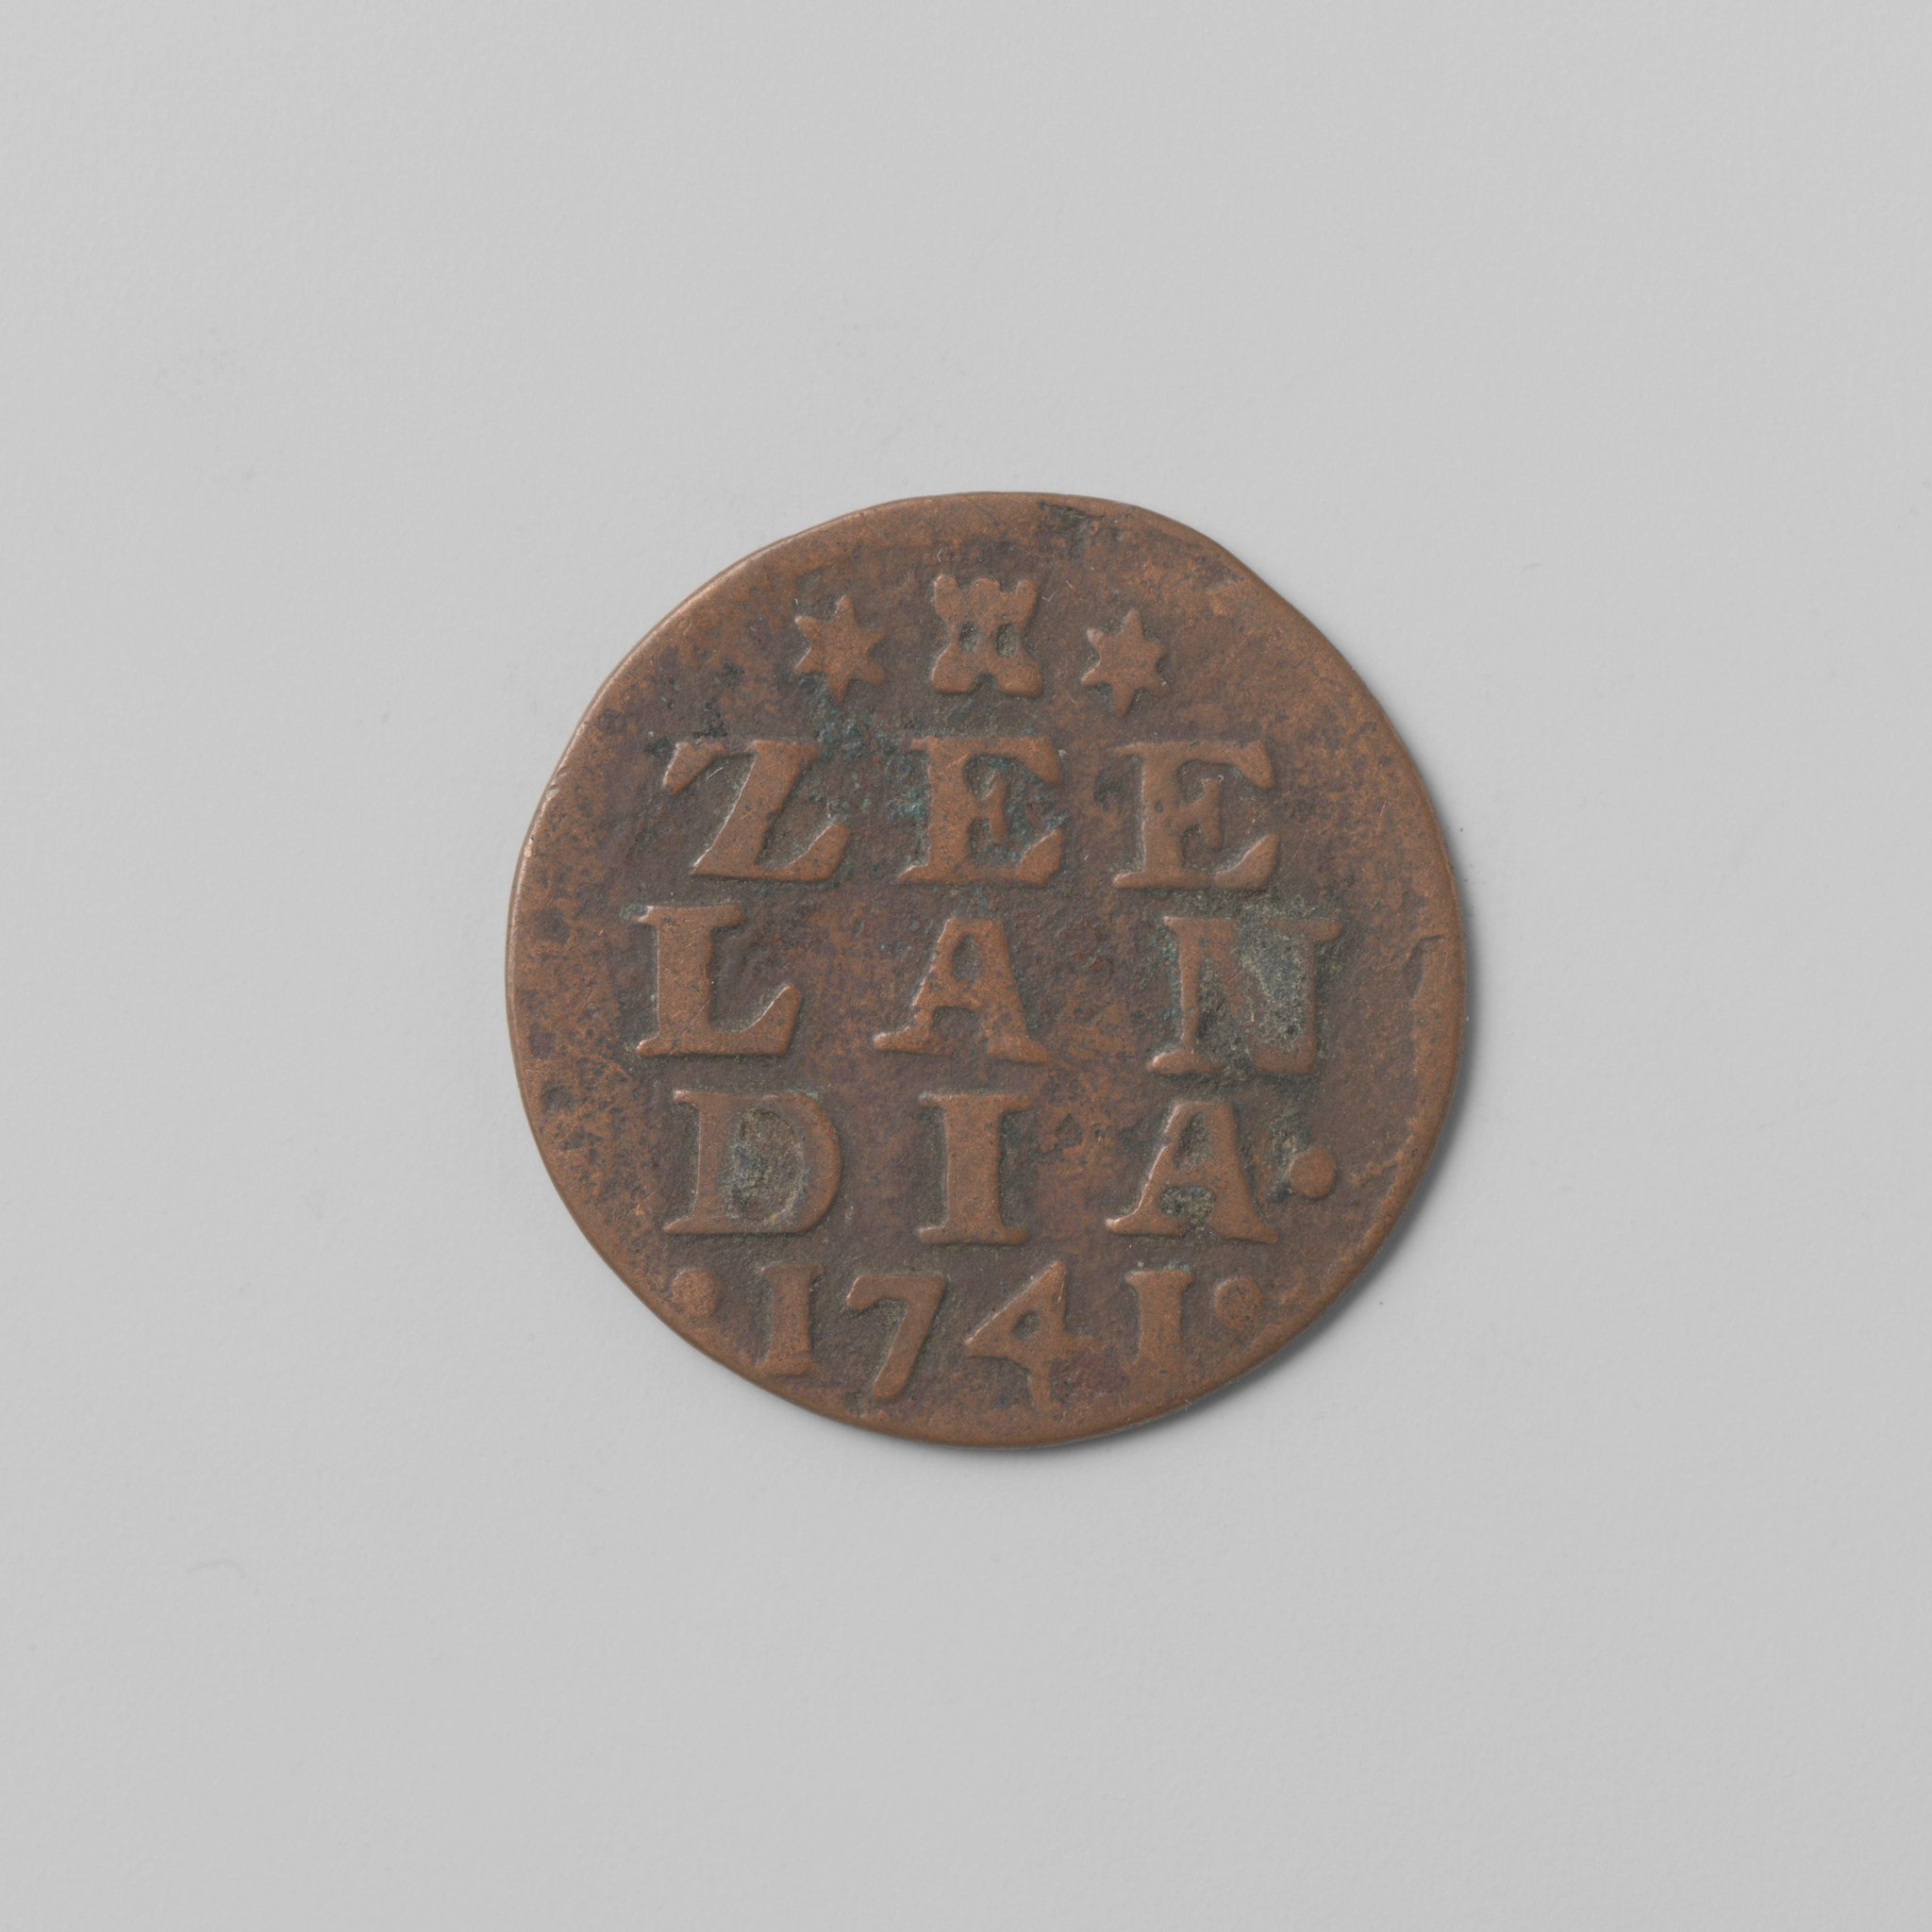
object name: coin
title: Zeeuwse duit, 1741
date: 1741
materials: copper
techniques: striking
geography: middelburg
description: Koperen munt. Voorzijde: gekroond, zijdelings ingedeukt wapenschild van Zeeland. Keerzijde: opschrift in drie regels, waarboven muntteken burcht tussen twee sterren en waaronder jaartal.